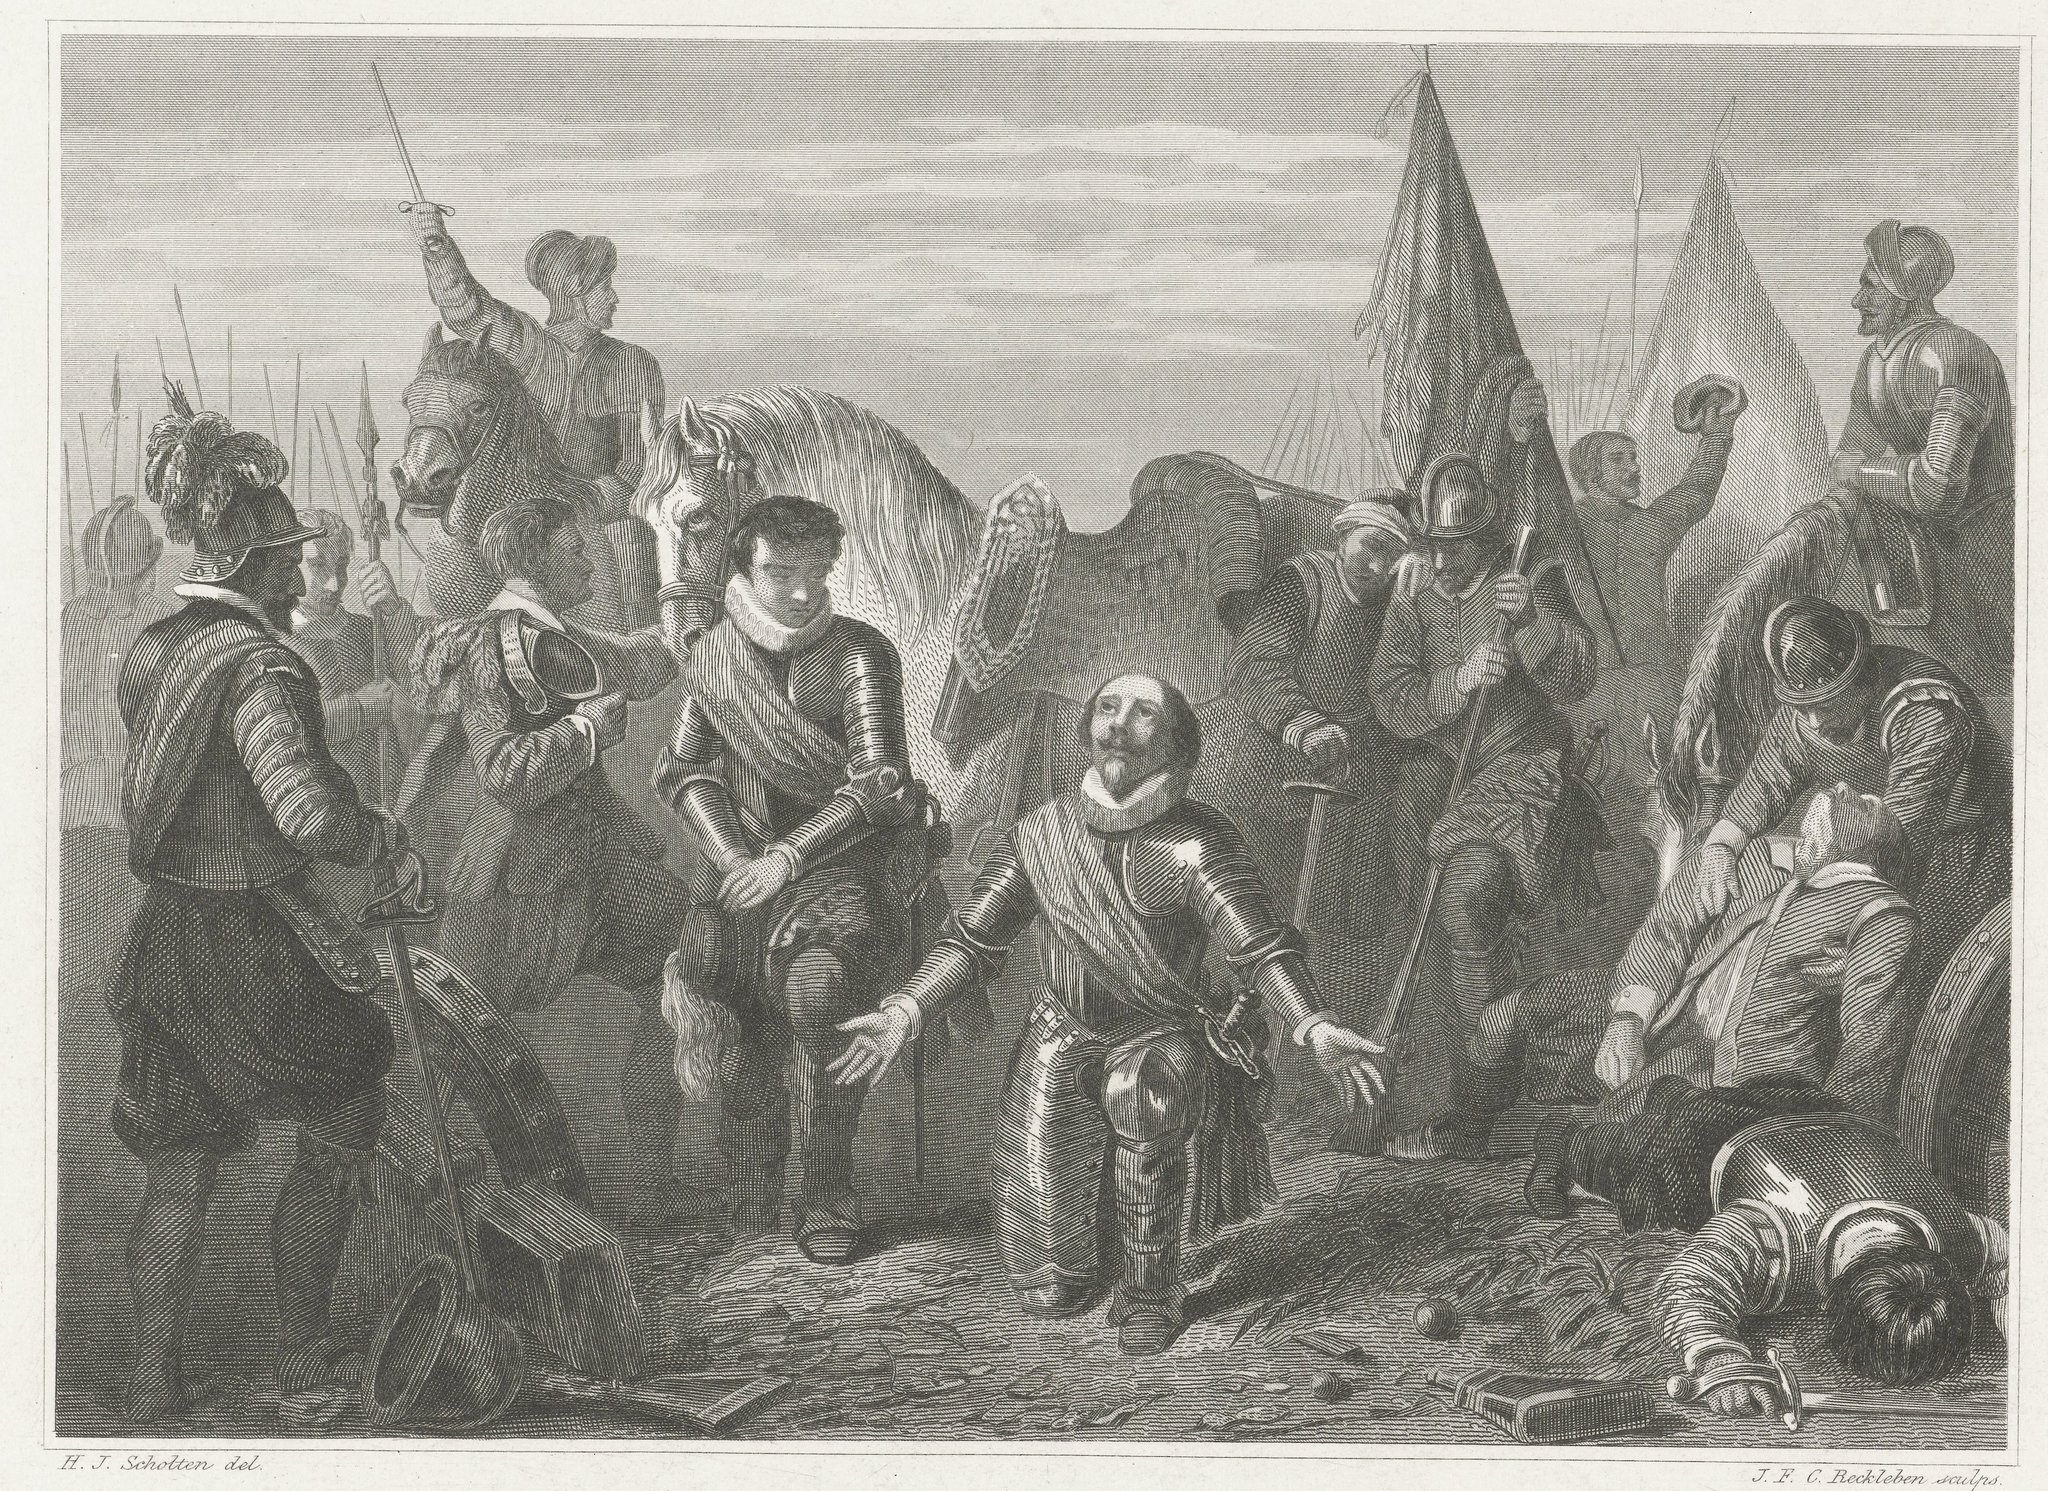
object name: history print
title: Maurits knielt in dank na de overwinning bij de slag bij Nieuwpoort, 1600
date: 1880-1882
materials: paper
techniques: engraving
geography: netherlands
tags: the hague, maurice (prince of orange), victor (after the battle), victory ~ armed conflict (+ land forces), battle of nieuwpoort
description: Gebruikt als illustratie in: J.P. Arend, Algemeene geschiedenis des vaderlands, Amsterdam, 5 delen, 1840-1882, dl. V (1882), p. 152/153.